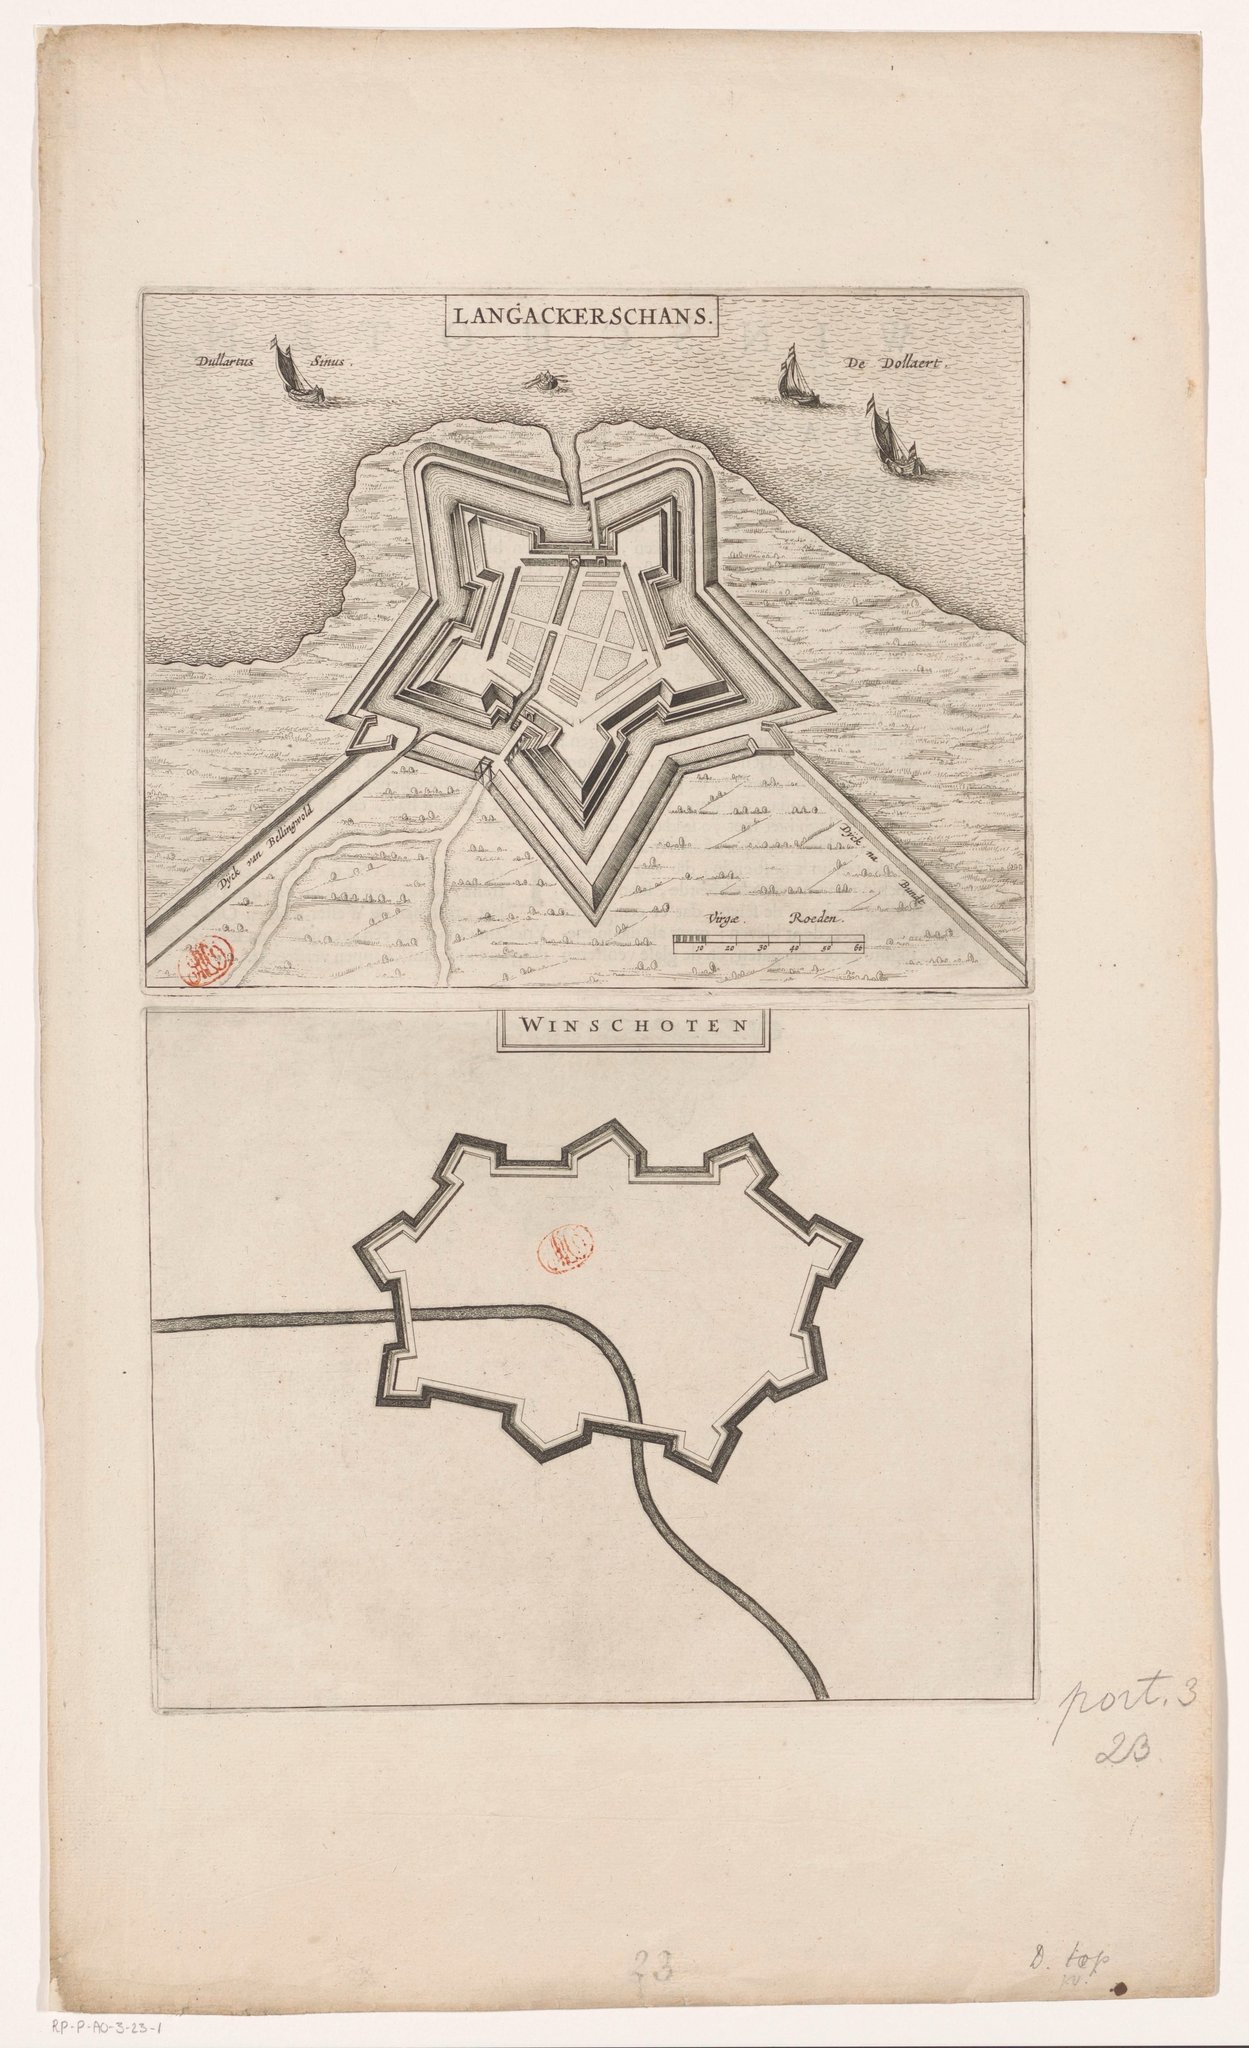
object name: area plan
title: Langackerschans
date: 1652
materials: paper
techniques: engraving, etching, letterpress printing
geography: amsterdam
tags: fortress, maps of cities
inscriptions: collector's mark: Lugt 195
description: Boven een vestingplattegrond van Nieuweschans ('Langackerschans') met daarop rechtsonder een schaalstok: Virgae / Roeden. Onder een vestingplattegrond van Winschoten. Op verso Nederlandse tekst.